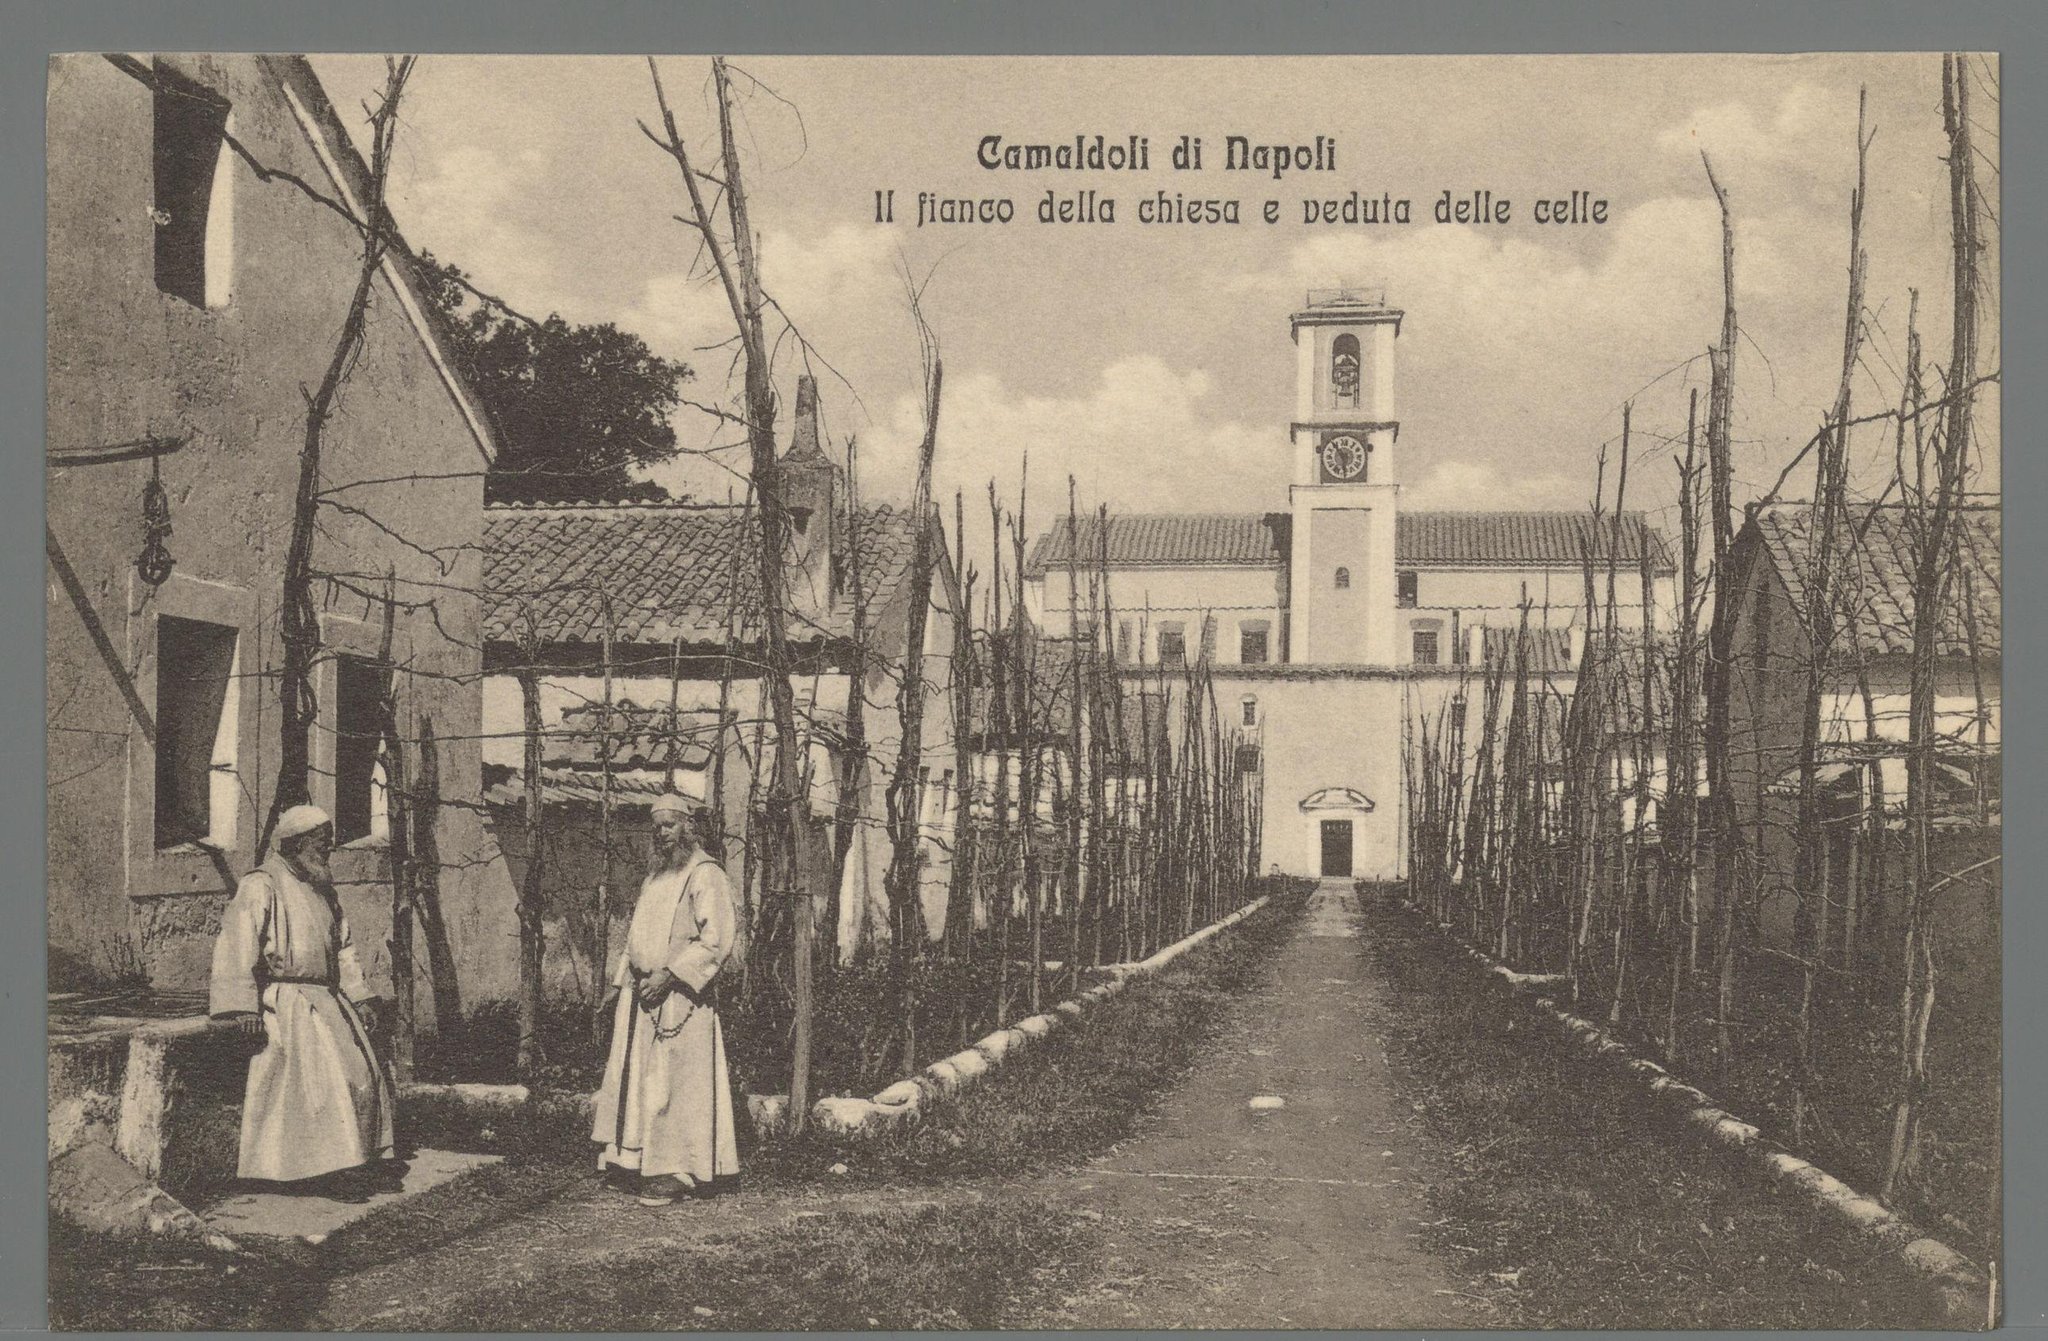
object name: ansichtkaart, prentbriefkaart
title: Camaldoli di Napoli. Il fianco della chiesa e veduta delle celle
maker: Anonymous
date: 1906-1910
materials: cardboard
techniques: photograph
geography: terni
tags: church (exterior), monk(s), friar(s), abbey garden, camaldoli